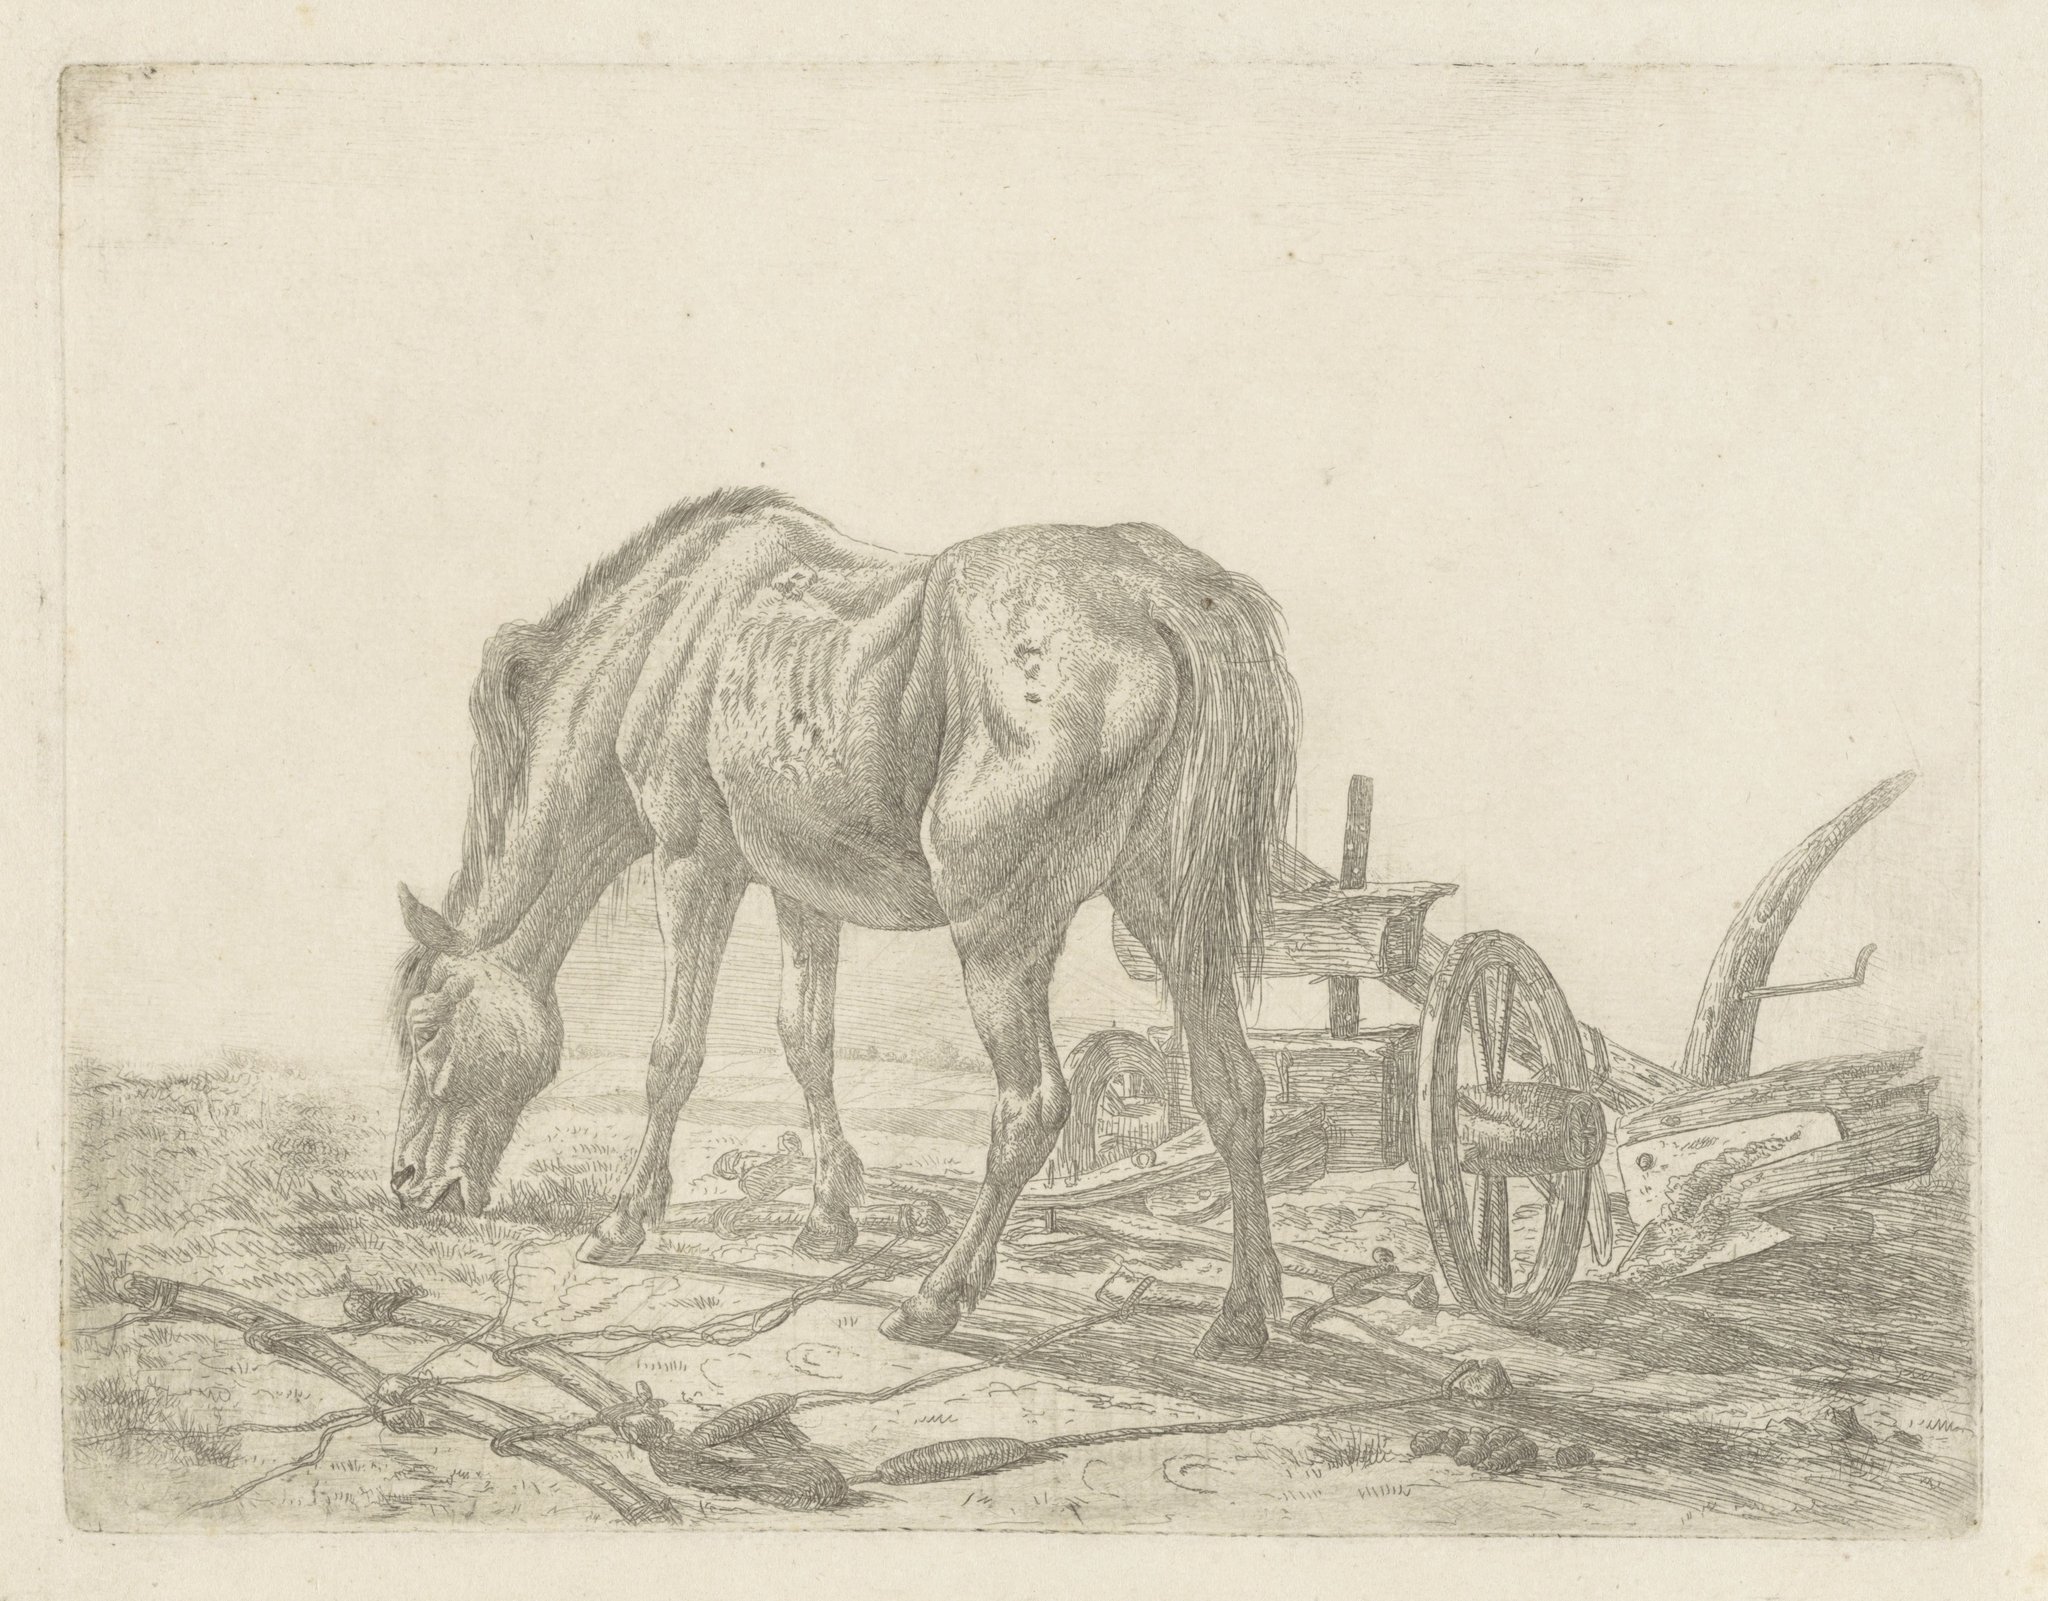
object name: print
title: Uitgespannen paard bij een ploeg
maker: abraham hendrik winter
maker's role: painter, print maker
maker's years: 1800-1861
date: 1815-1860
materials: paper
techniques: etching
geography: utrecht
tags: horse, agricultural implements: plough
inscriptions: collector's mark: Lugt 2228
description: Een uitgespannen paard staat te grazen bij een ploeg. Rechtsvoor enkele paardenvijgen.